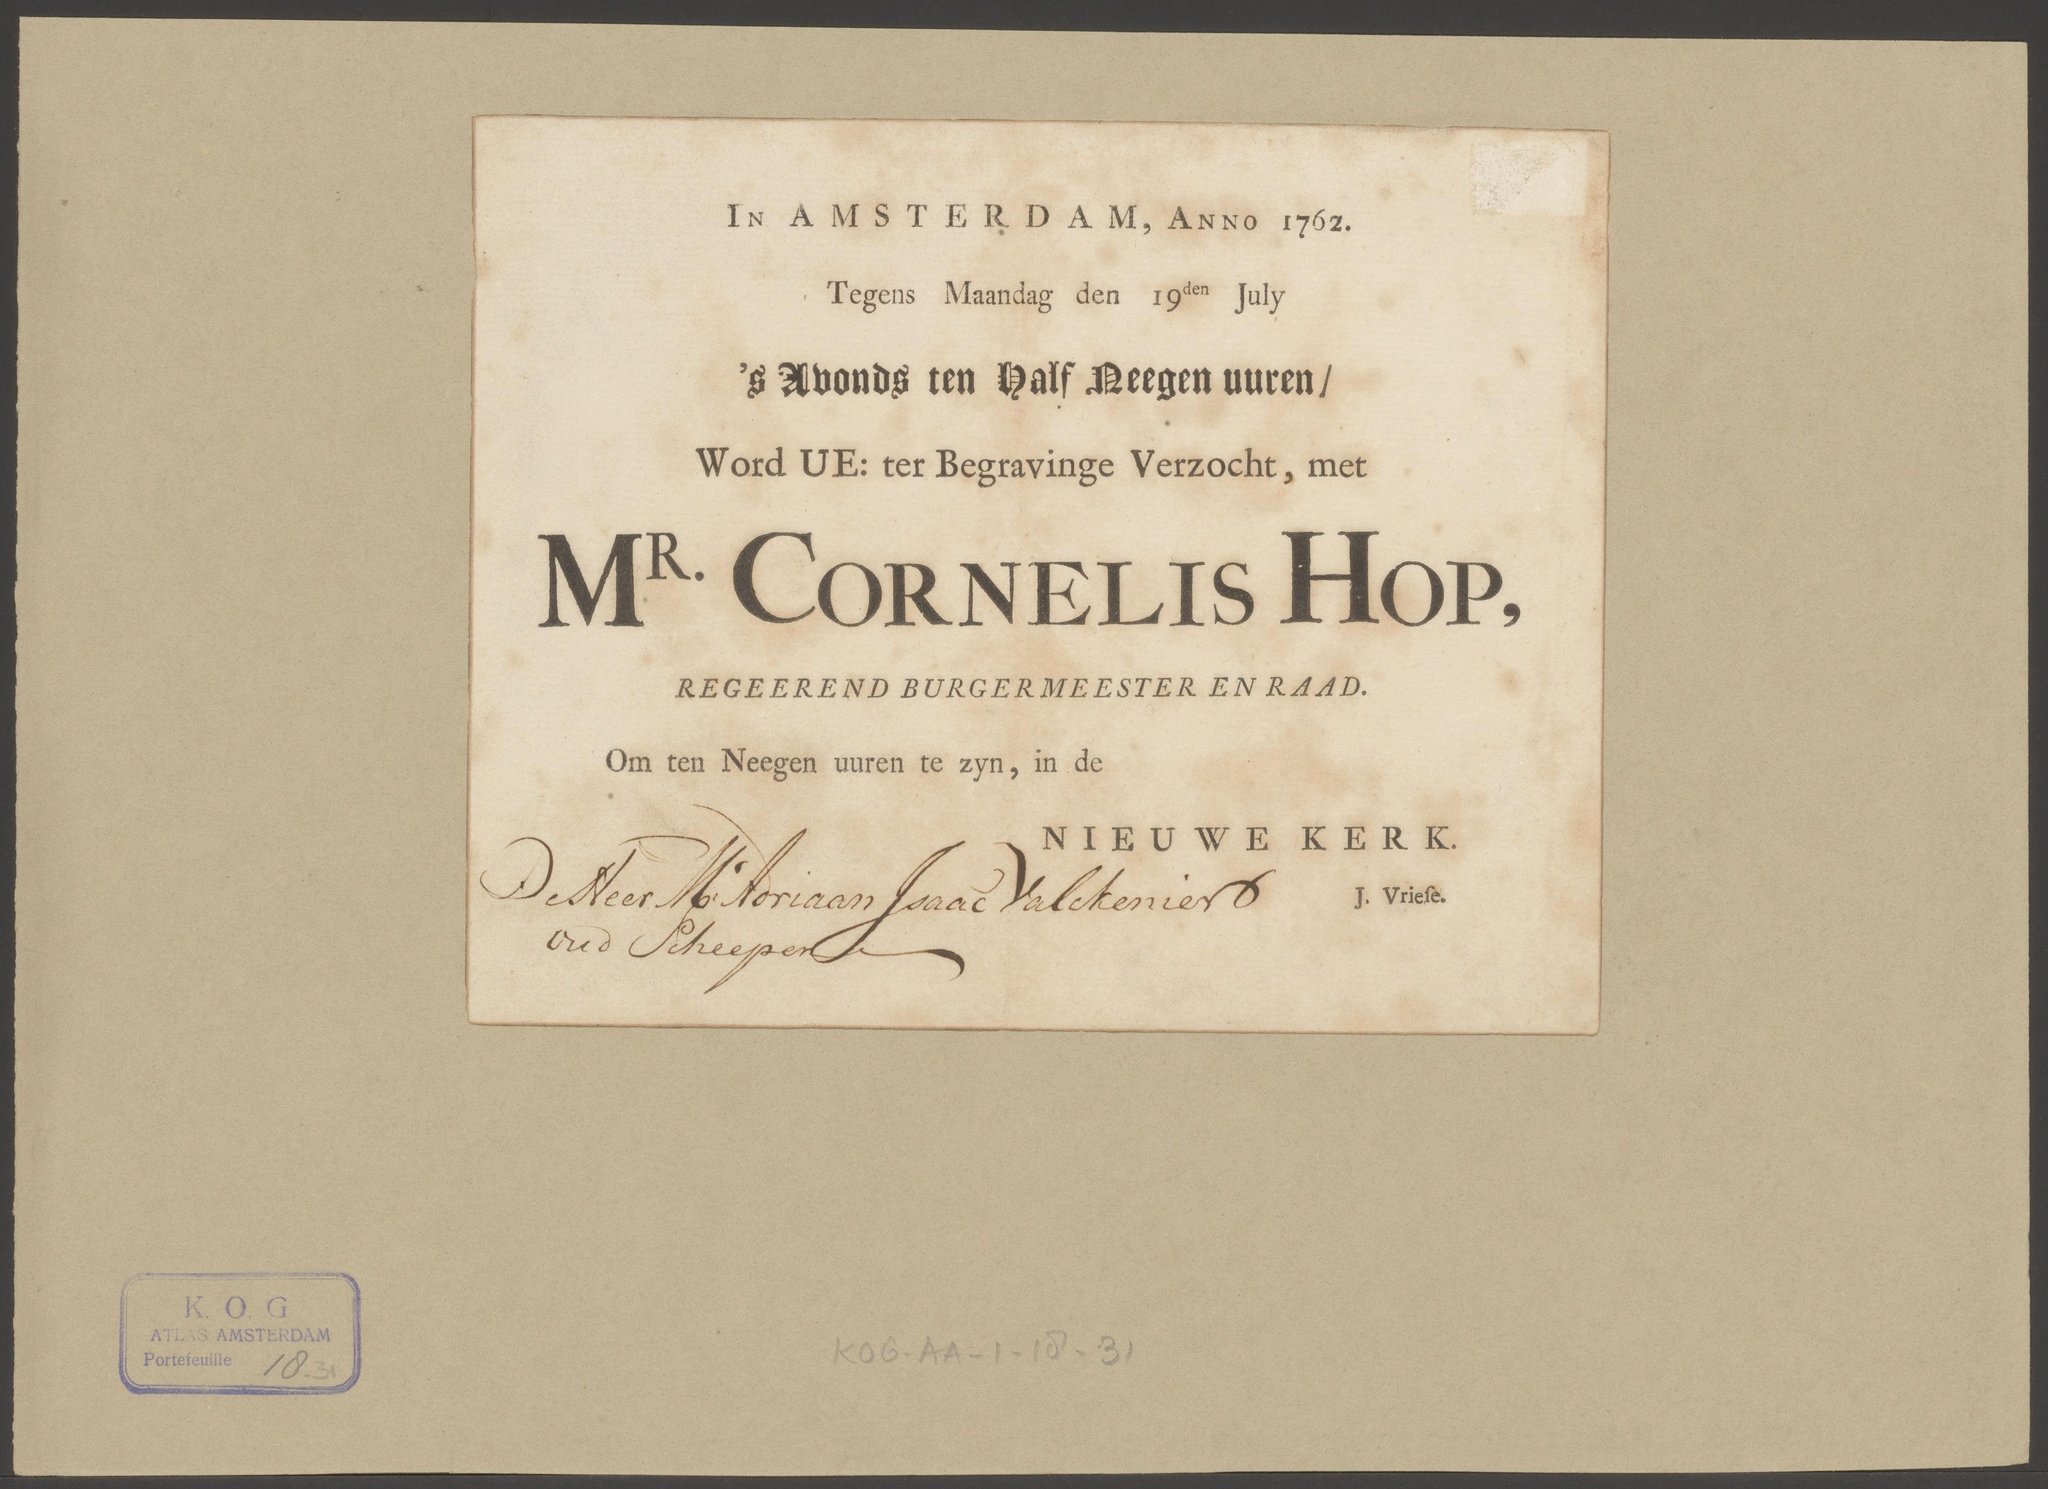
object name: text sheet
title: Begrafenisbriefje van Cornelis Hop, 19 juli 1762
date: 1707-1762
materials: ink, paper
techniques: letterpress printing, pen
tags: mayor, burgomaster, funerary ceremonial, amsterdam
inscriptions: collector's mark: ‘18.31’ Lugt 1641b, name: ‘De Heer Mr Adriaen Isaac Valckenier / oud Scheepen’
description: Onderwerpsrubriek binnen de Atlas Amsterdam: Herinneringen aan regeringsleden en hunne huisgezinnen [voor 1800].